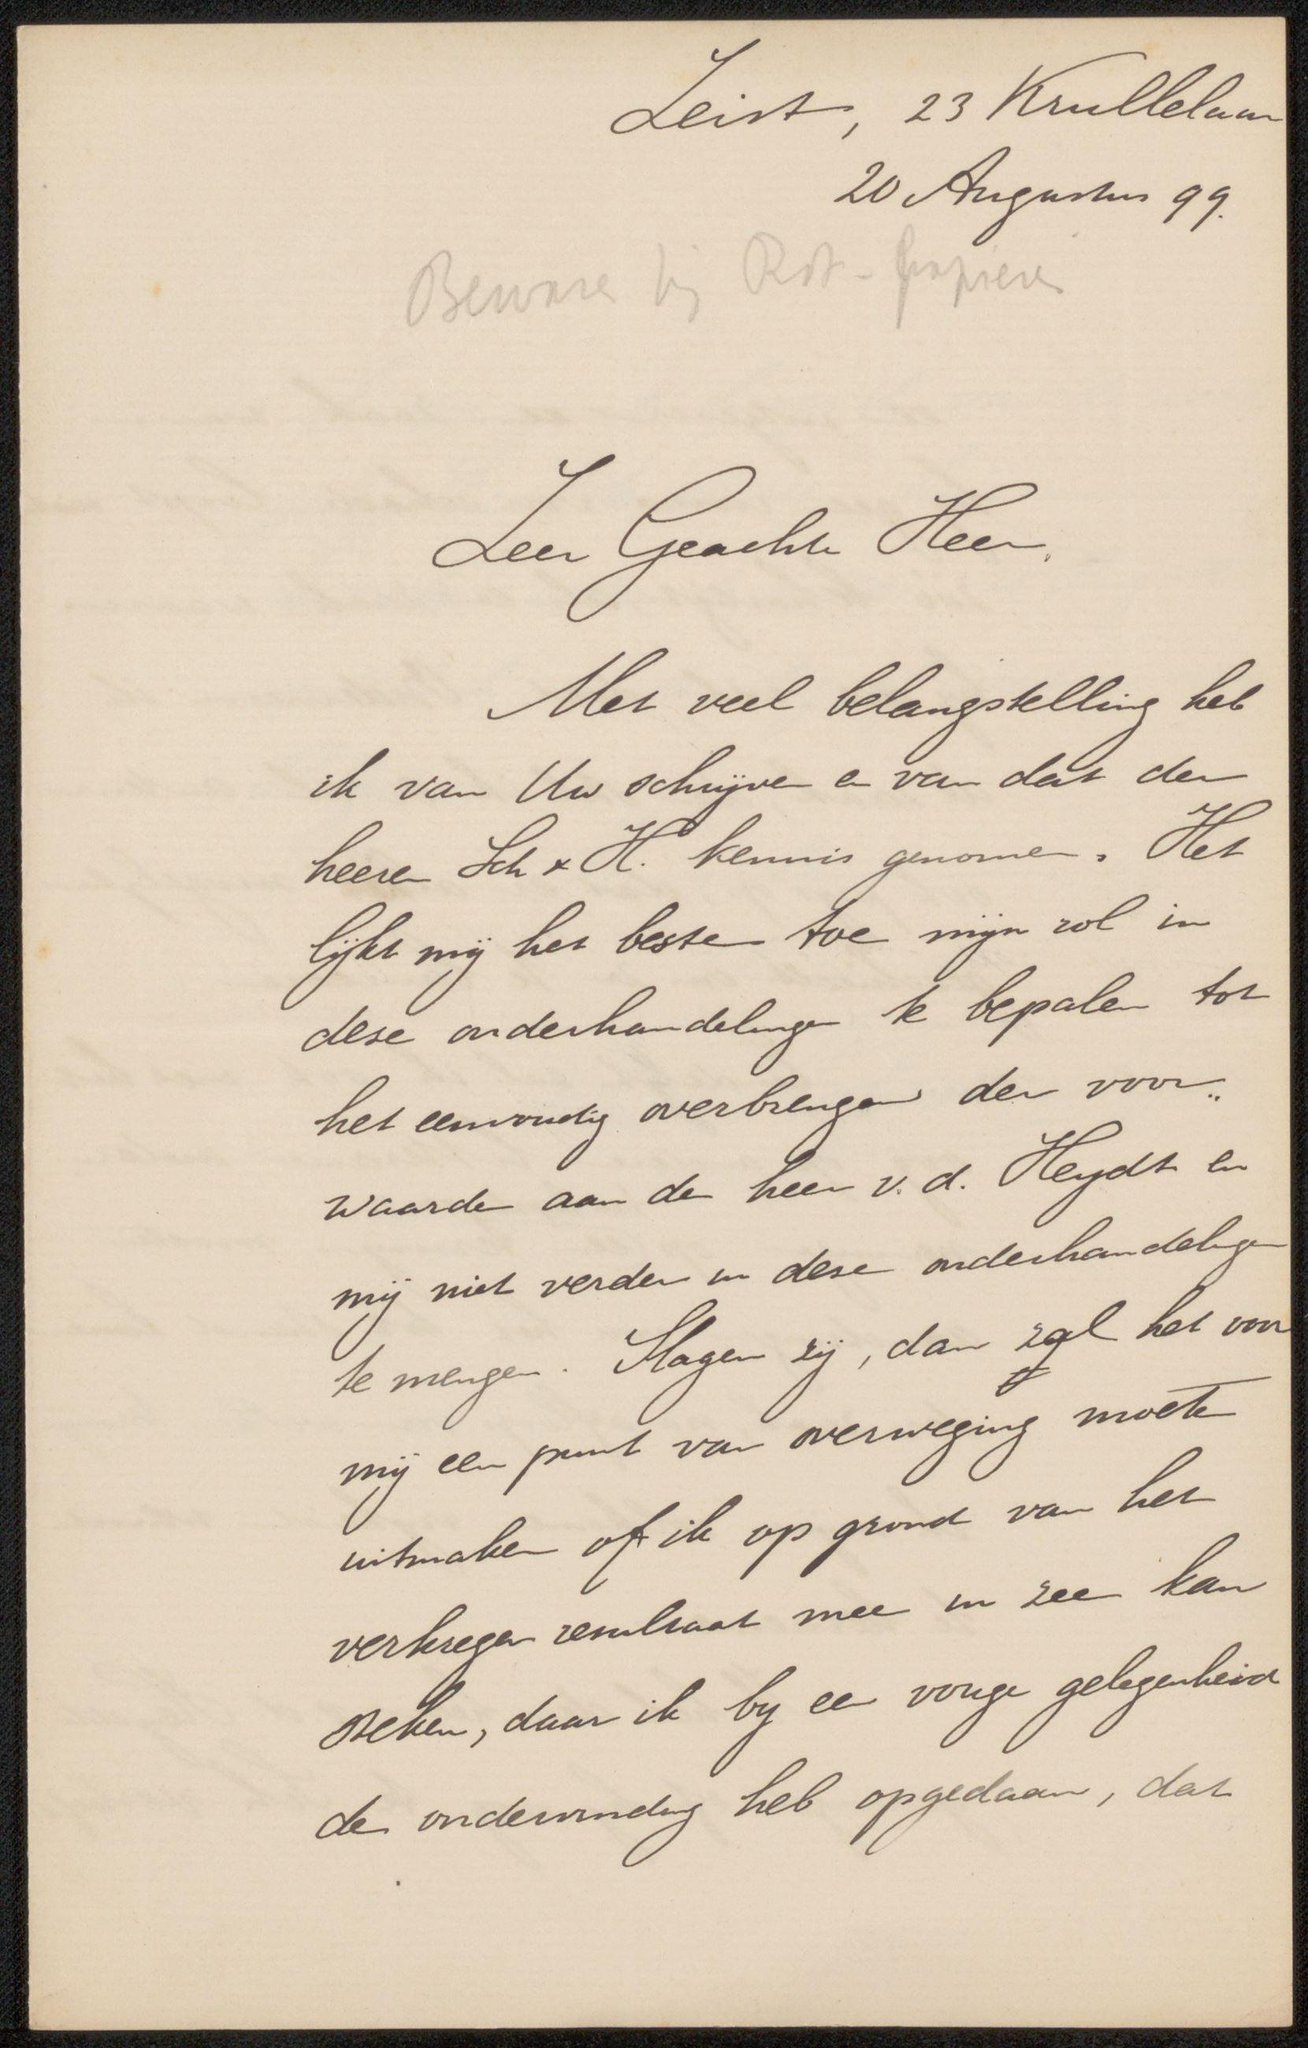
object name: letter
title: Brief aan Jan Veth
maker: cornelis hofstede de groot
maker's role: kunsthistoricus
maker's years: 1863-1940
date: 1899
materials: ink, paper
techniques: pen, writing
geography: zeist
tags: dordrecht, amsterdam, painter, print maker, draughtsman, designer, jan veth, money, printed matter, belgium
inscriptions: collector's mark: ‘RPK’